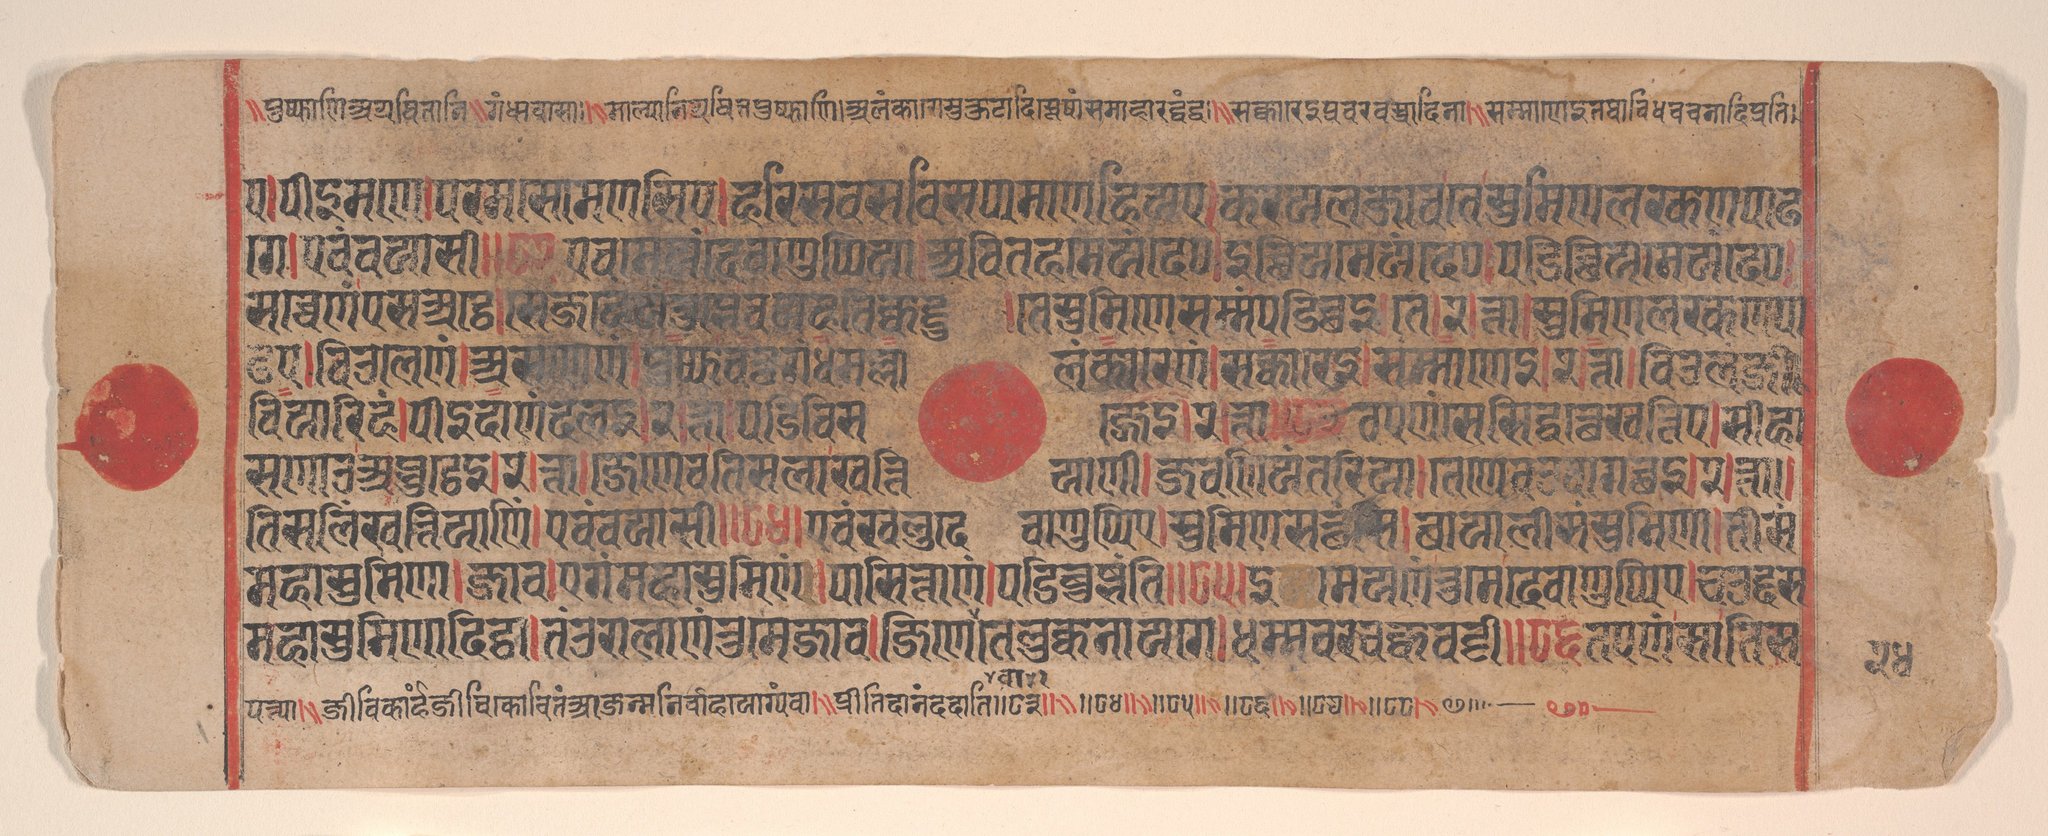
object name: folio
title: Leaf from a Kalpa Sutra (Jain Book of Rituals)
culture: indian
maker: bhadrabahu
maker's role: artist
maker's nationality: indian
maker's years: 356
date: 1401-1500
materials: gold, ink, paper, watercolor